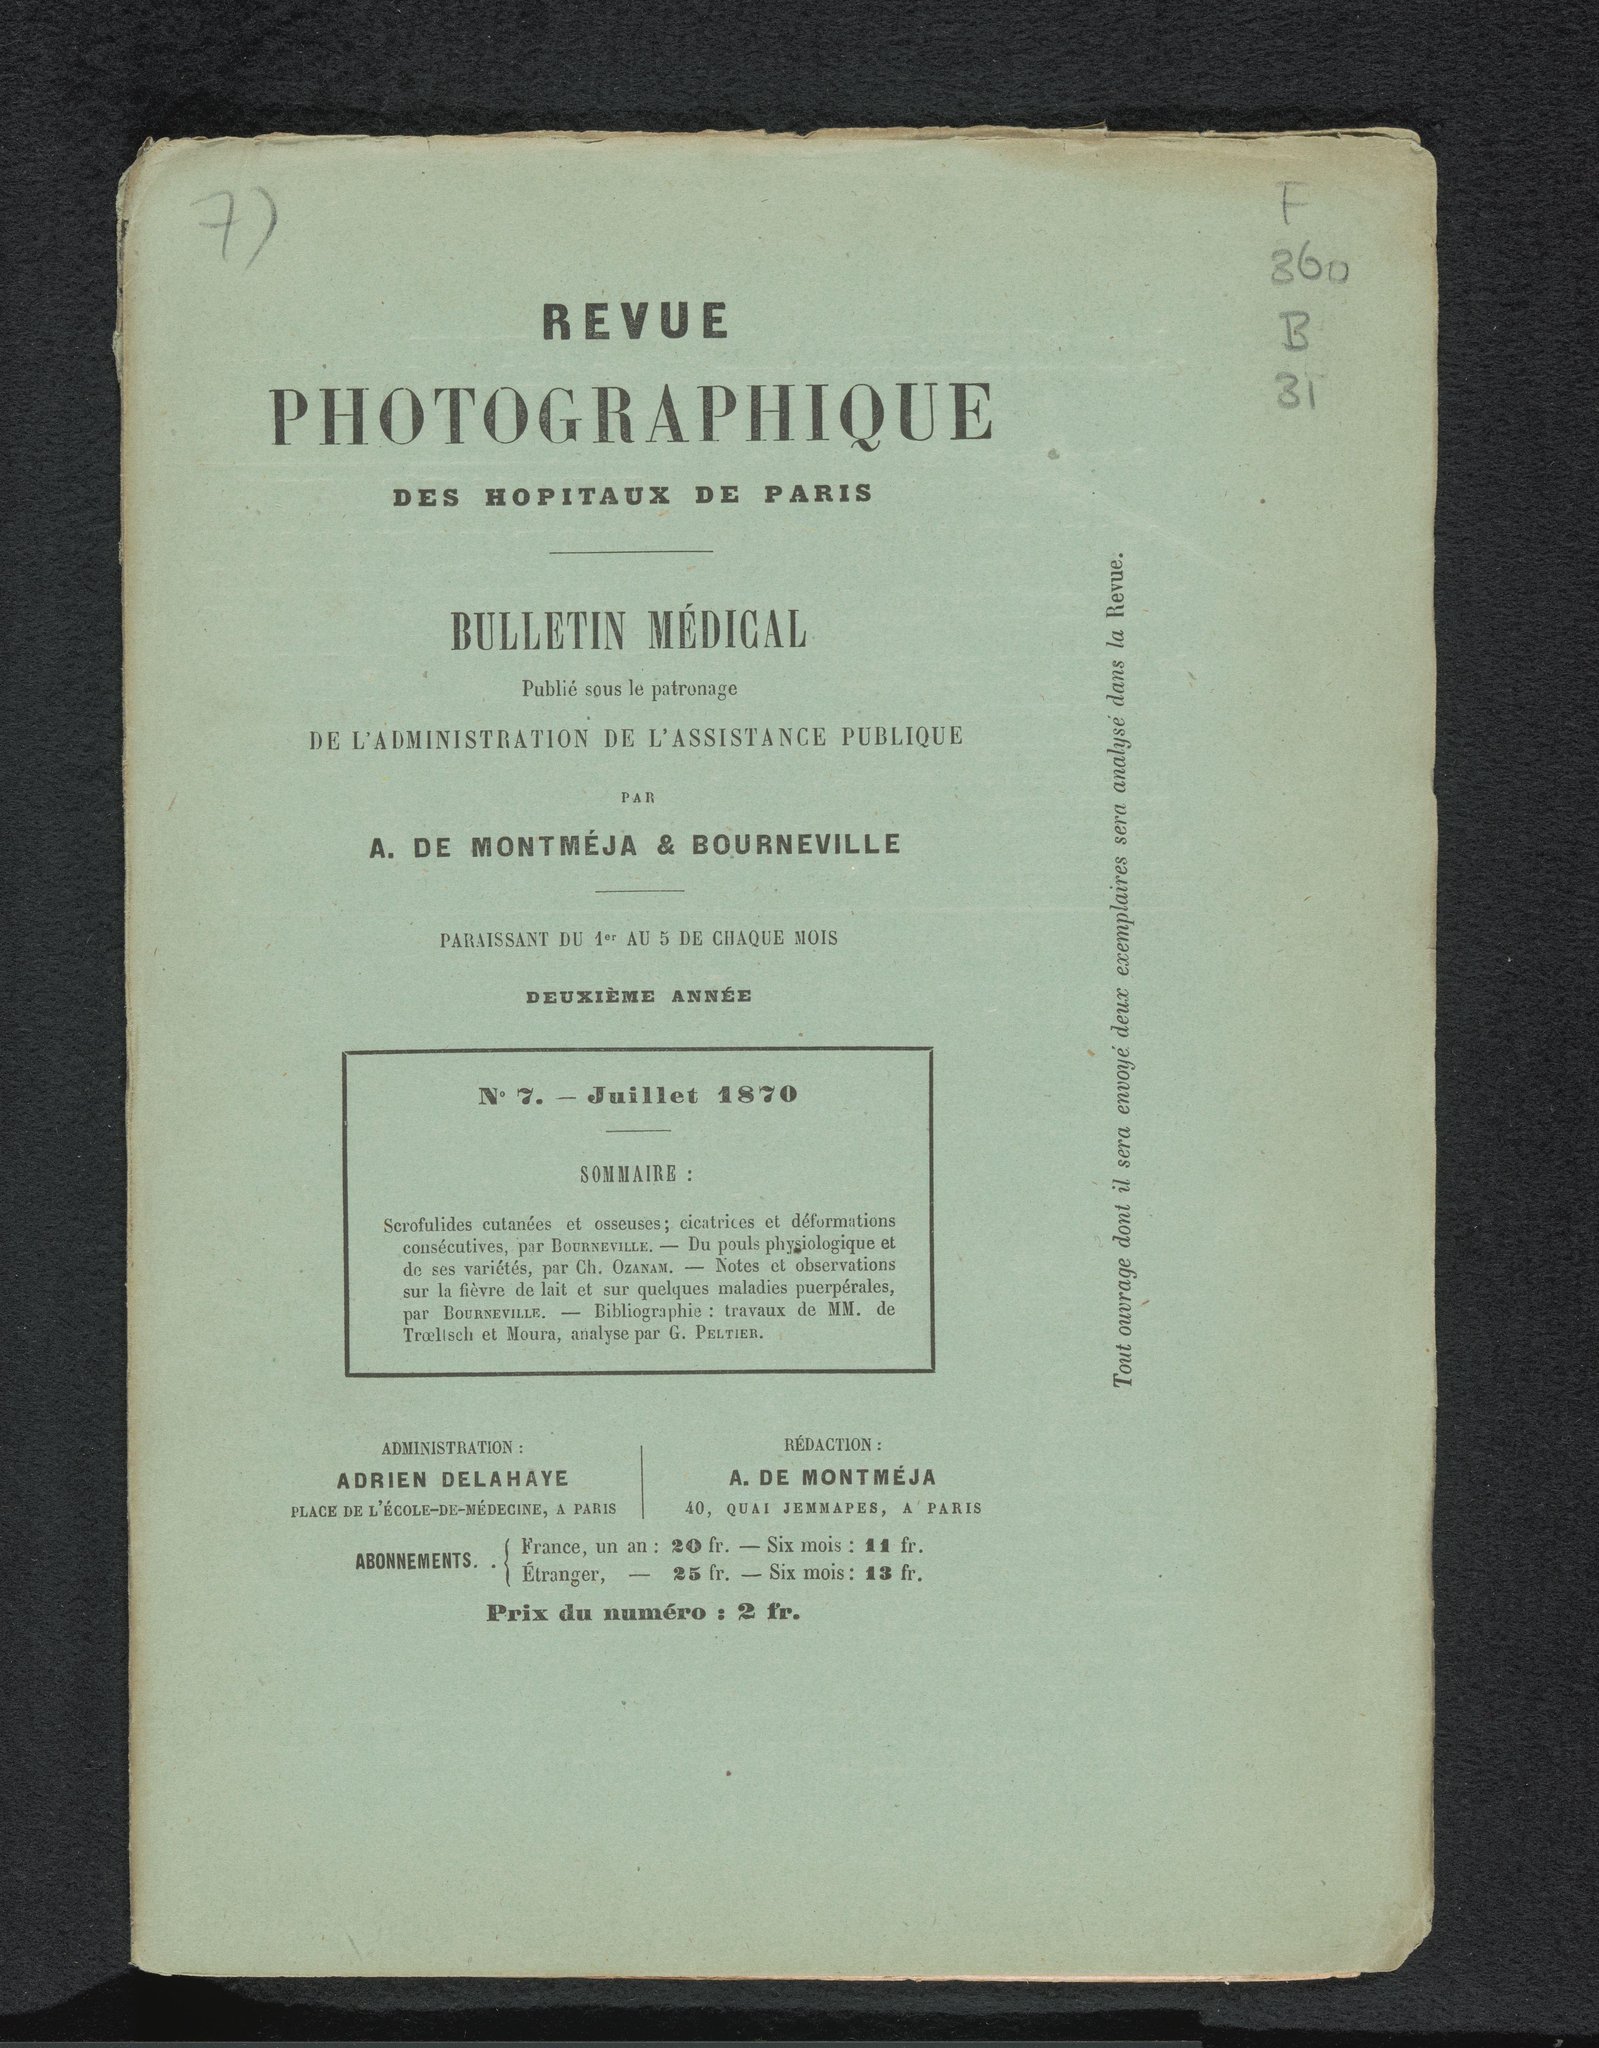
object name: magazine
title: Revue photographique des hôpitaux de Paris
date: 1870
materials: paper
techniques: printing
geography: paris